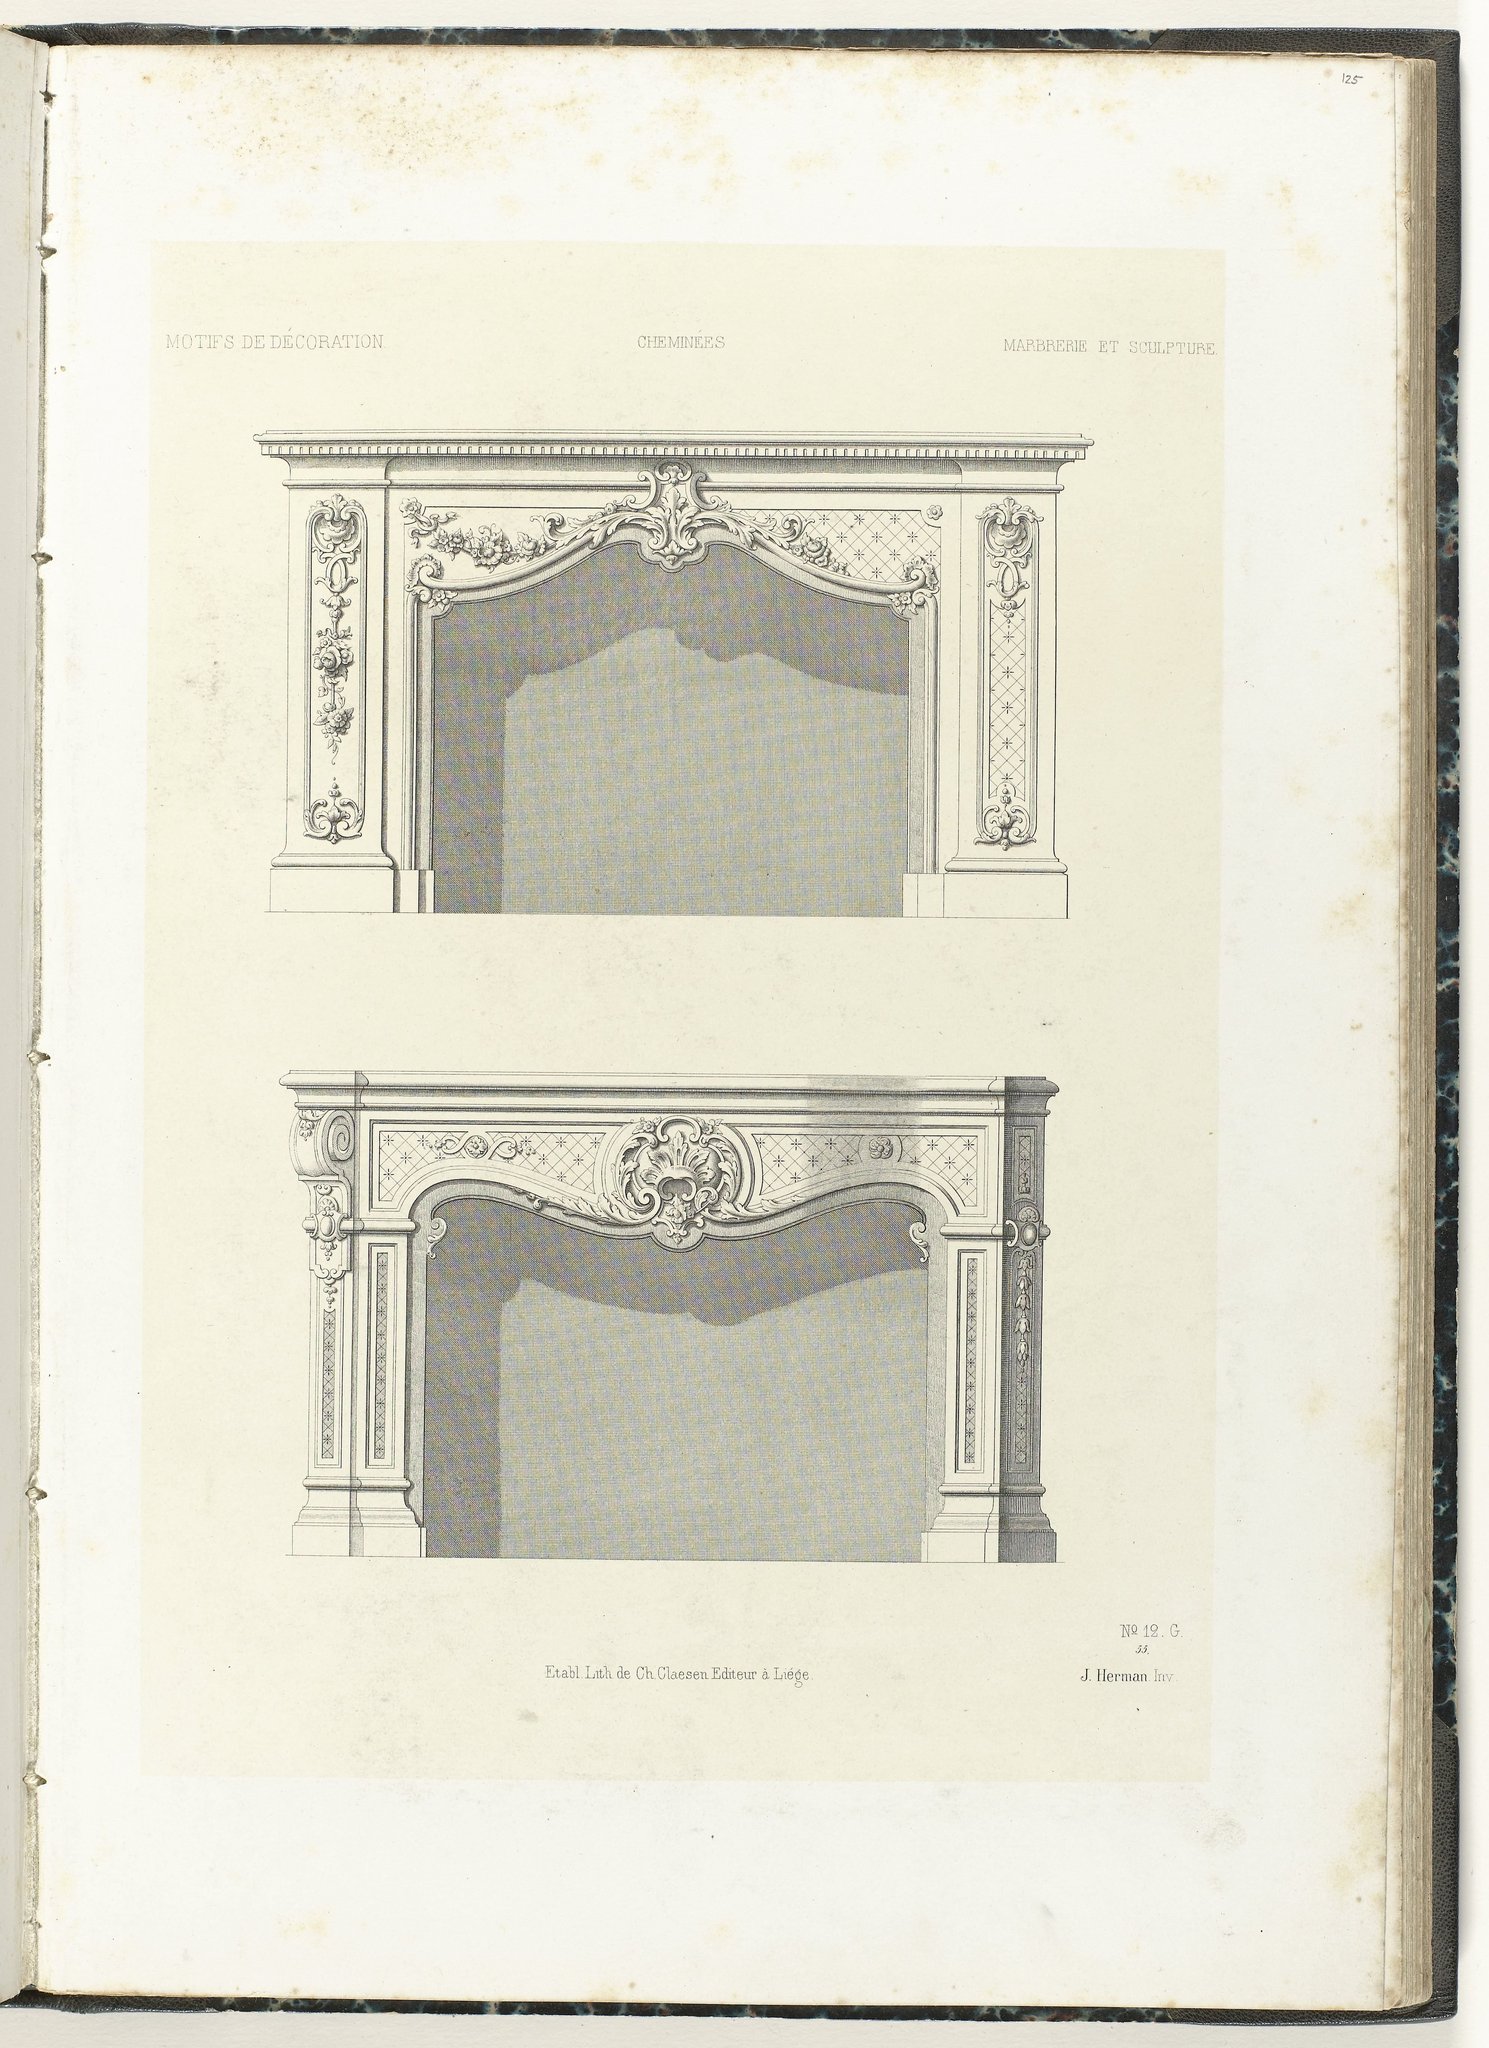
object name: print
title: Twee onderboezems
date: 1866-1900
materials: paper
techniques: tone lithography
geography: liège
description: Onderboezems met een variant voor de rechterhelft. De bovenste onderboezem is gedecoreerd met bladranken en bloemen, de onderste met een voluut aan de linkerkant. Linksboven staat: Motifs de décoration, rechtsboven: Marbrerie et sculpture, rechtsonder: N° 12. G. 55.